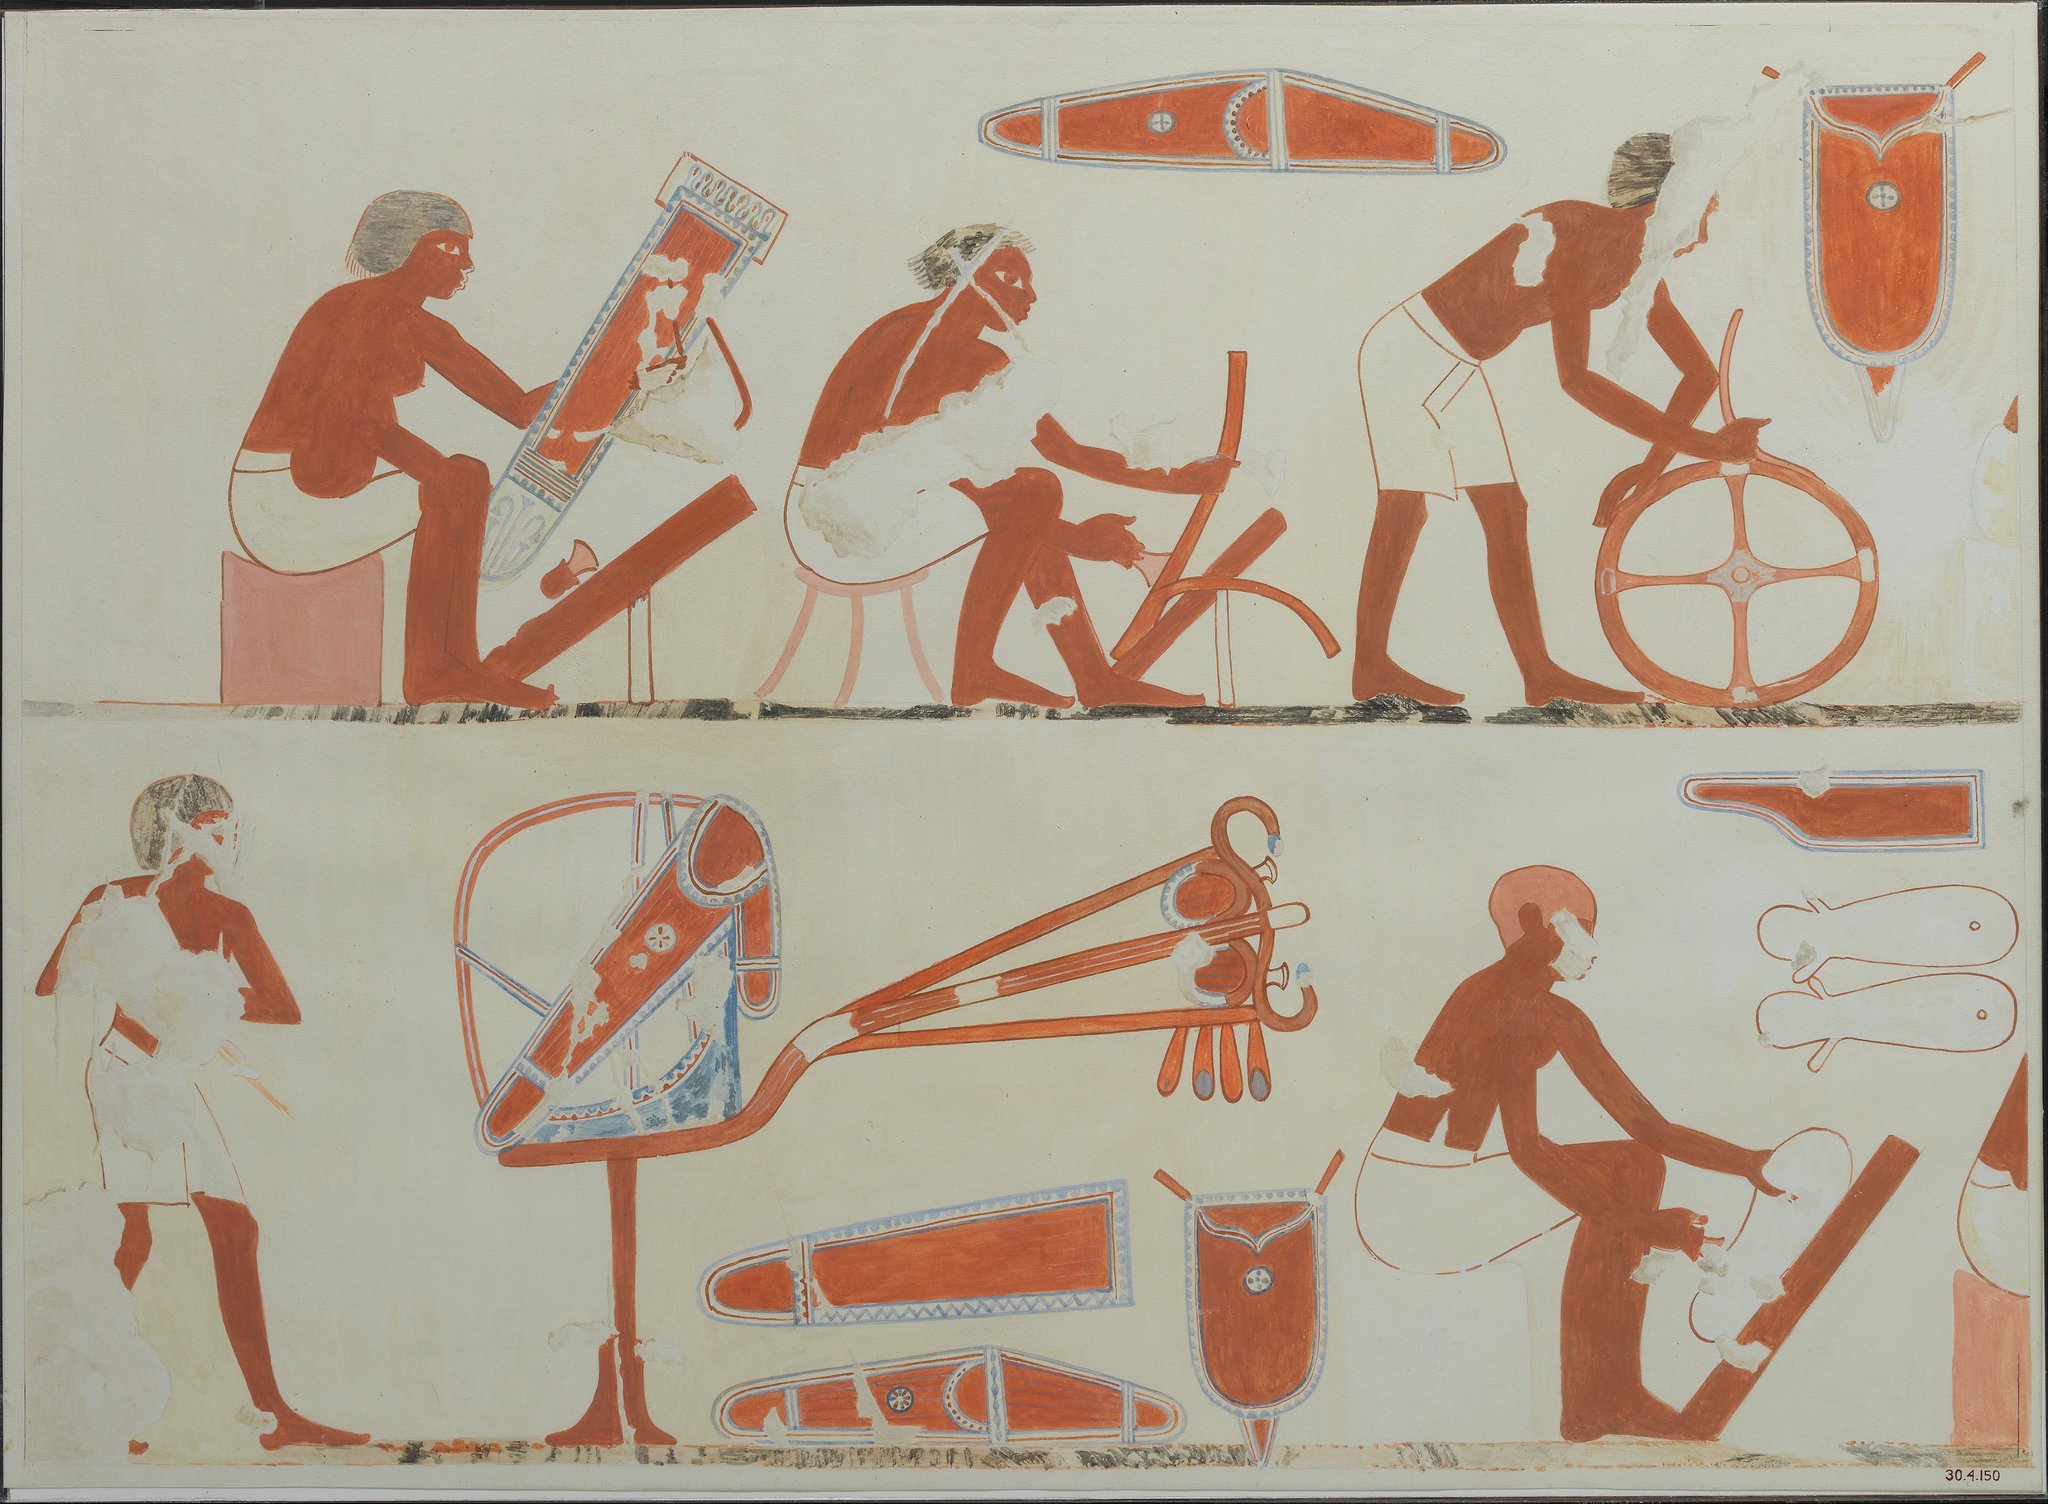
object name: facsimile, hapu tt 66, craftsman, wood, leather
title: Wood and Leather Craftsmen, Tomb of Hapu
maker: nina de garis davies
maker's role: artist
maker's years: 1881-1965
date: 1400-1390 BCE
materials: paper, paint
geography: egypt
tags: men,working